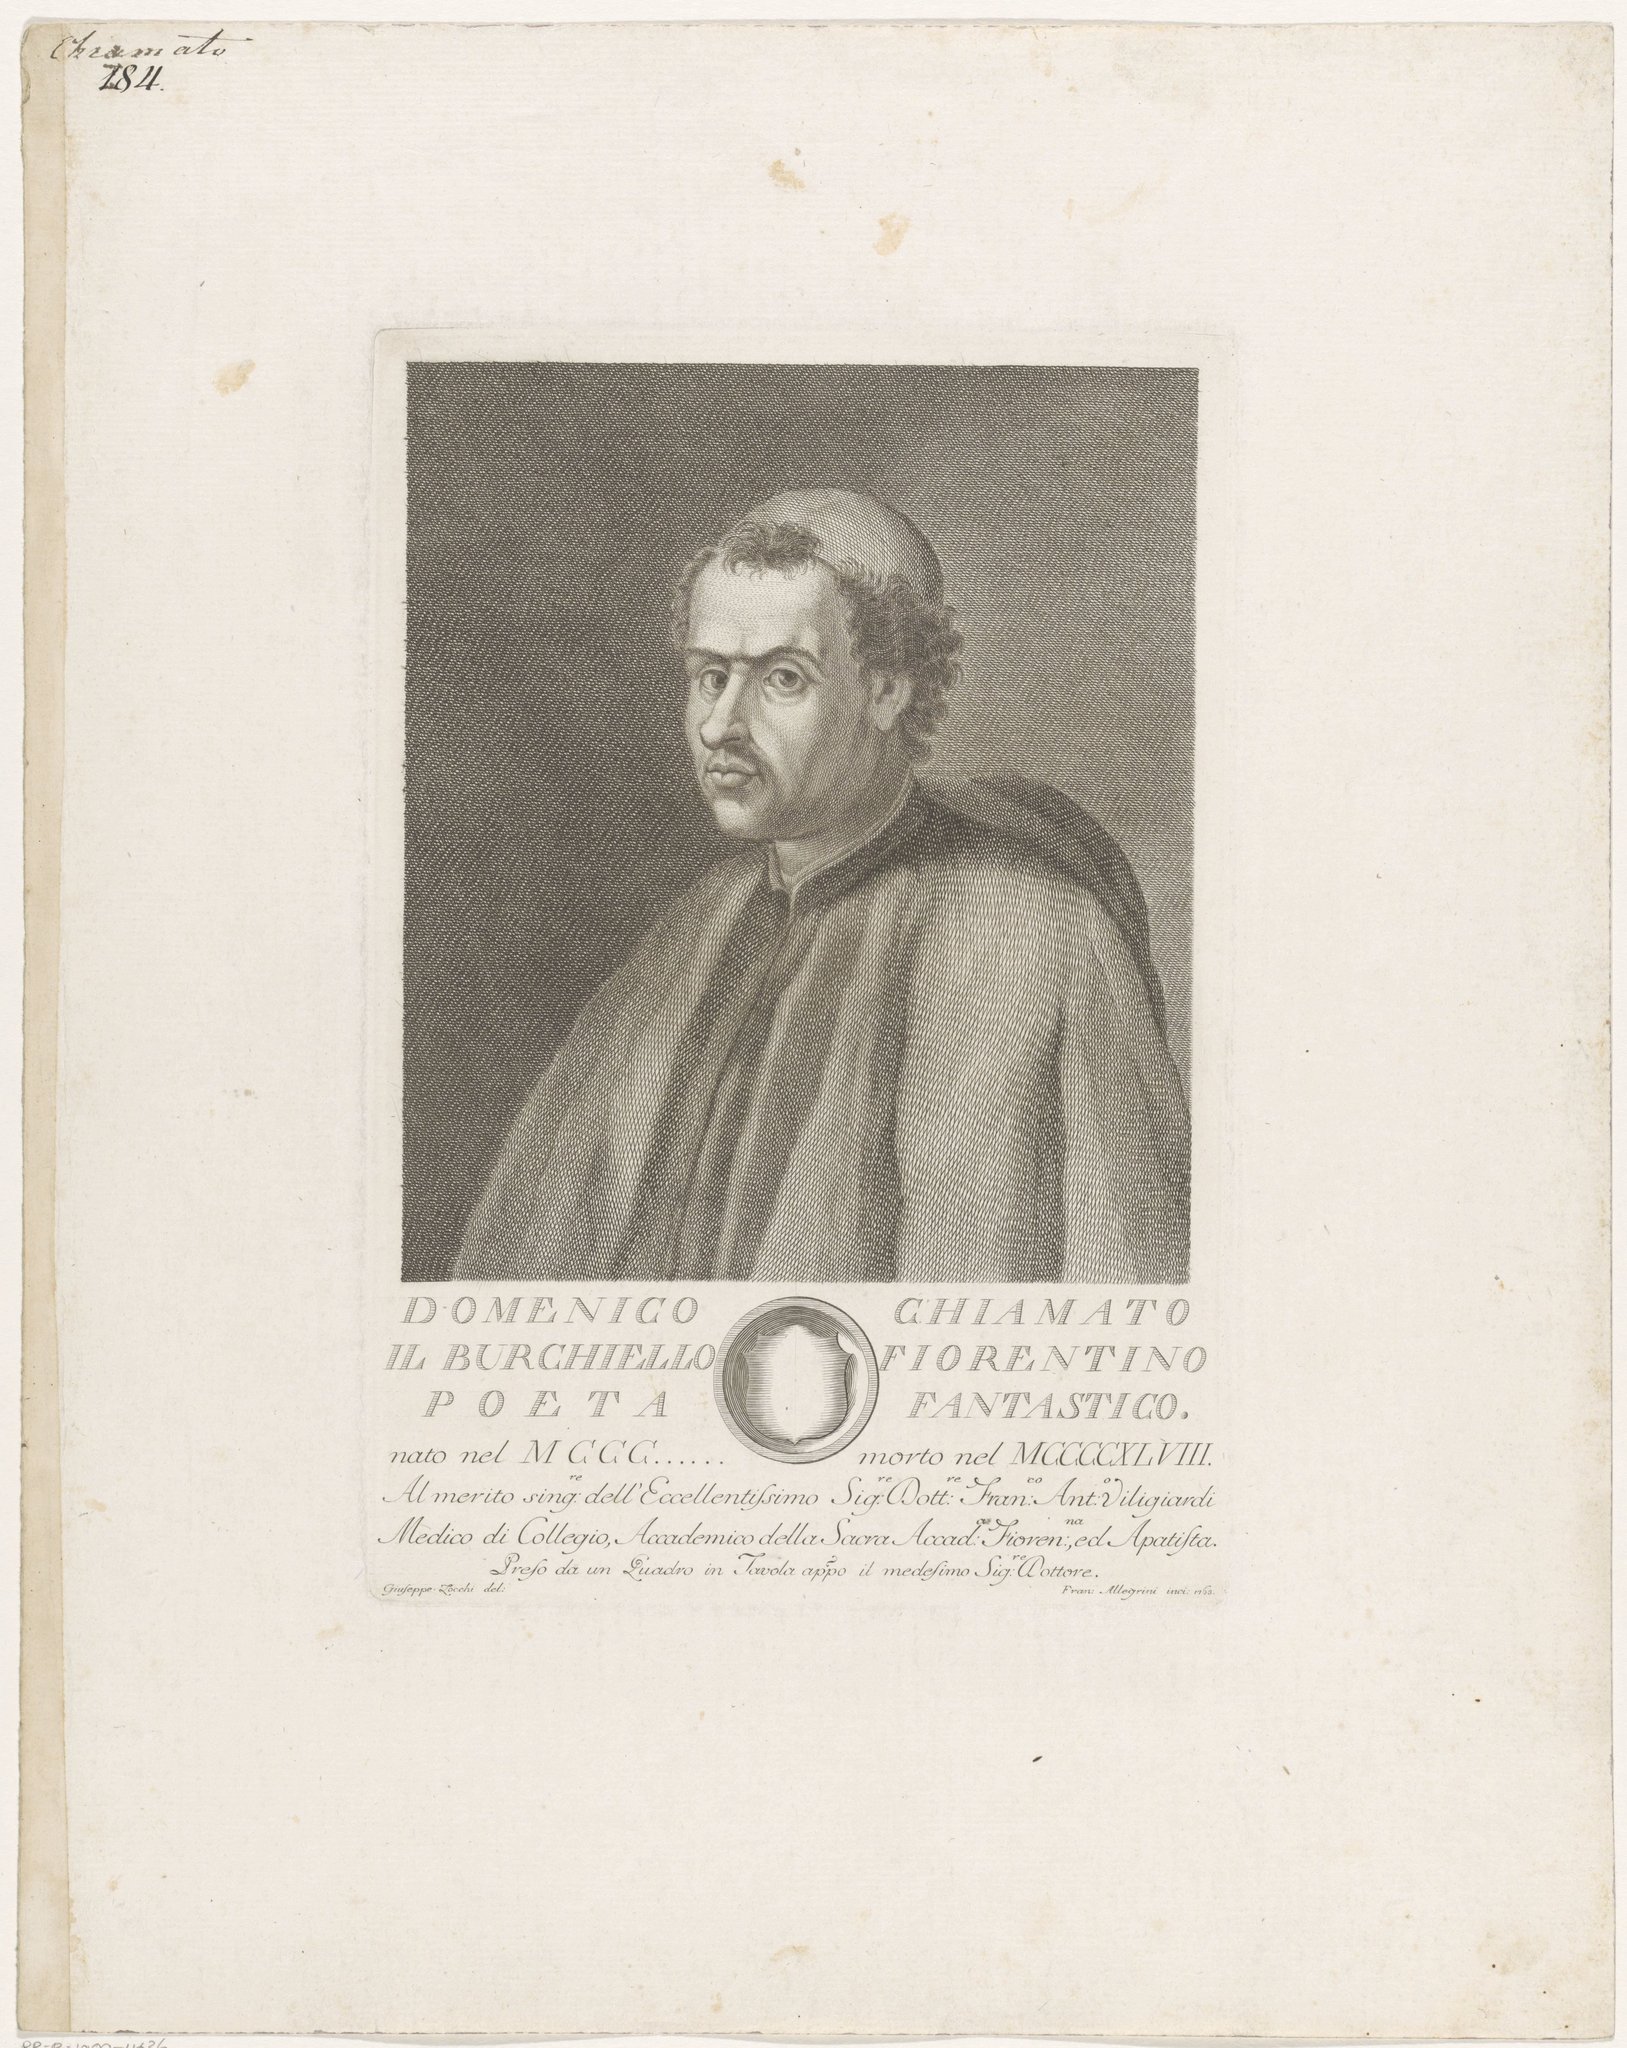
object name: print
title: Portret van Domenico di Giovanni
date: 1763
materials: paper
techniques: engraving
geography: florence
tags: rome, historical persons, portrait of a writer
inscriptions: collector's mark: Lugt 2228, inscription: ‘Chiamato / 784’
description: Deze prent maakt deel uit van een reeks portretprenten van onbekende omvang. De prenten zijn gemaakt door meedere prentmakers, onder wie Francesco Allegrini en Carlo en Raimondo Faucci.